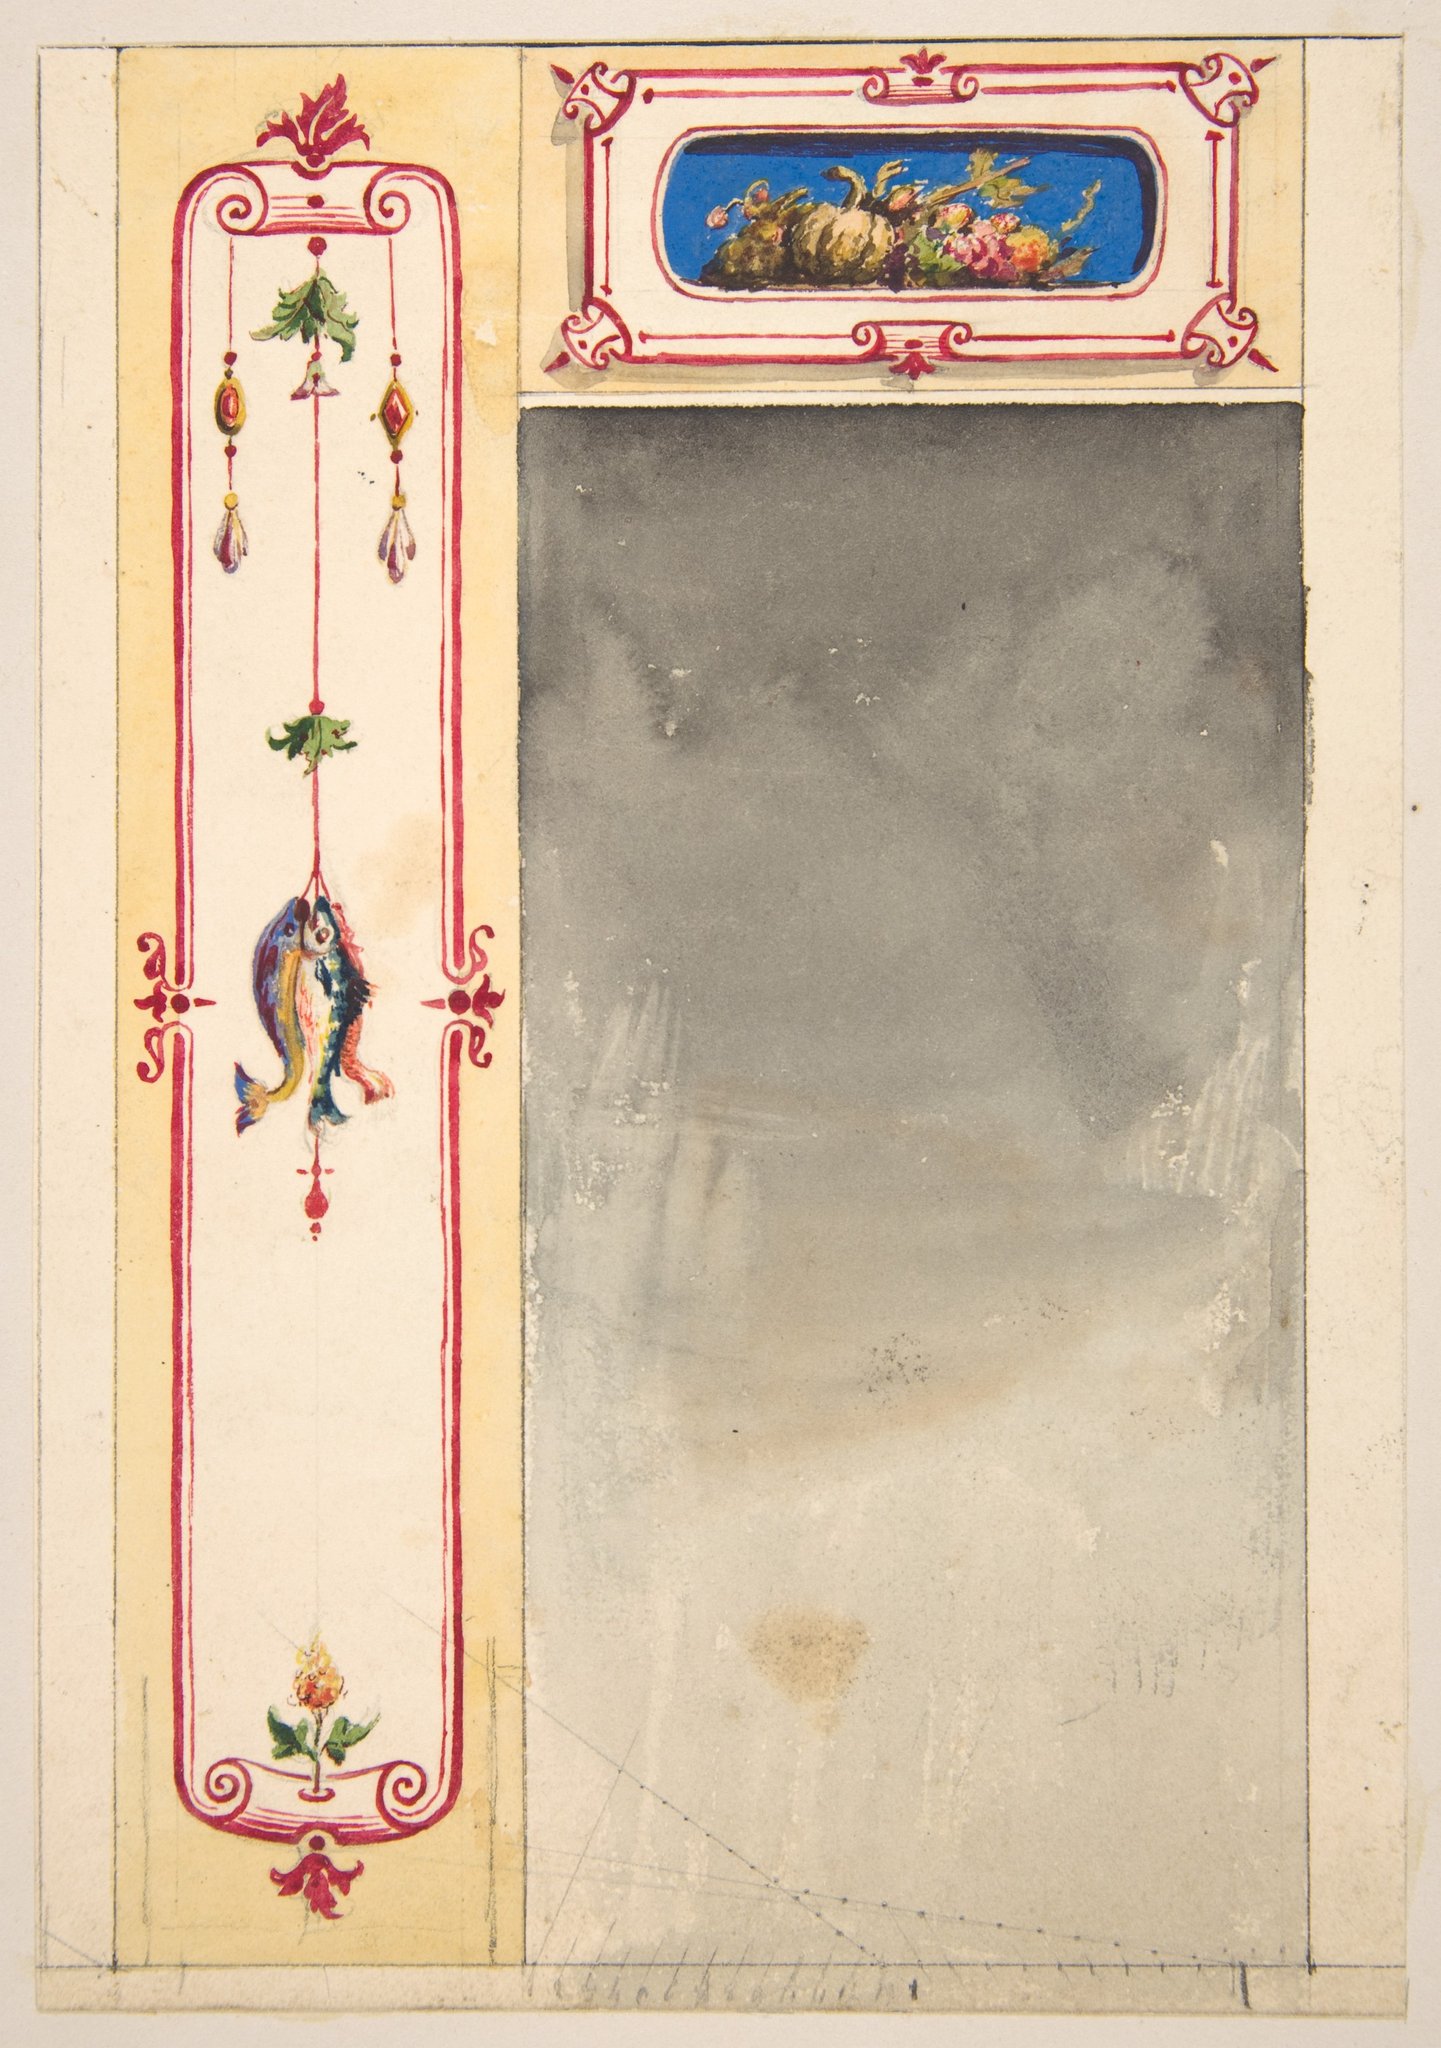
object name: drawing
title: Design for panels framing a mirror decorated with scrolls and clusters of fish and vegetables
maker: jules-edmond-charles lachaise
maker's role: artist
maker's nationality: french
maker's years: 1897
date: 1830-1897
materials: graphite, ink, watercolor, paper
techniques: pen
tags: fish,flowers,mirrors